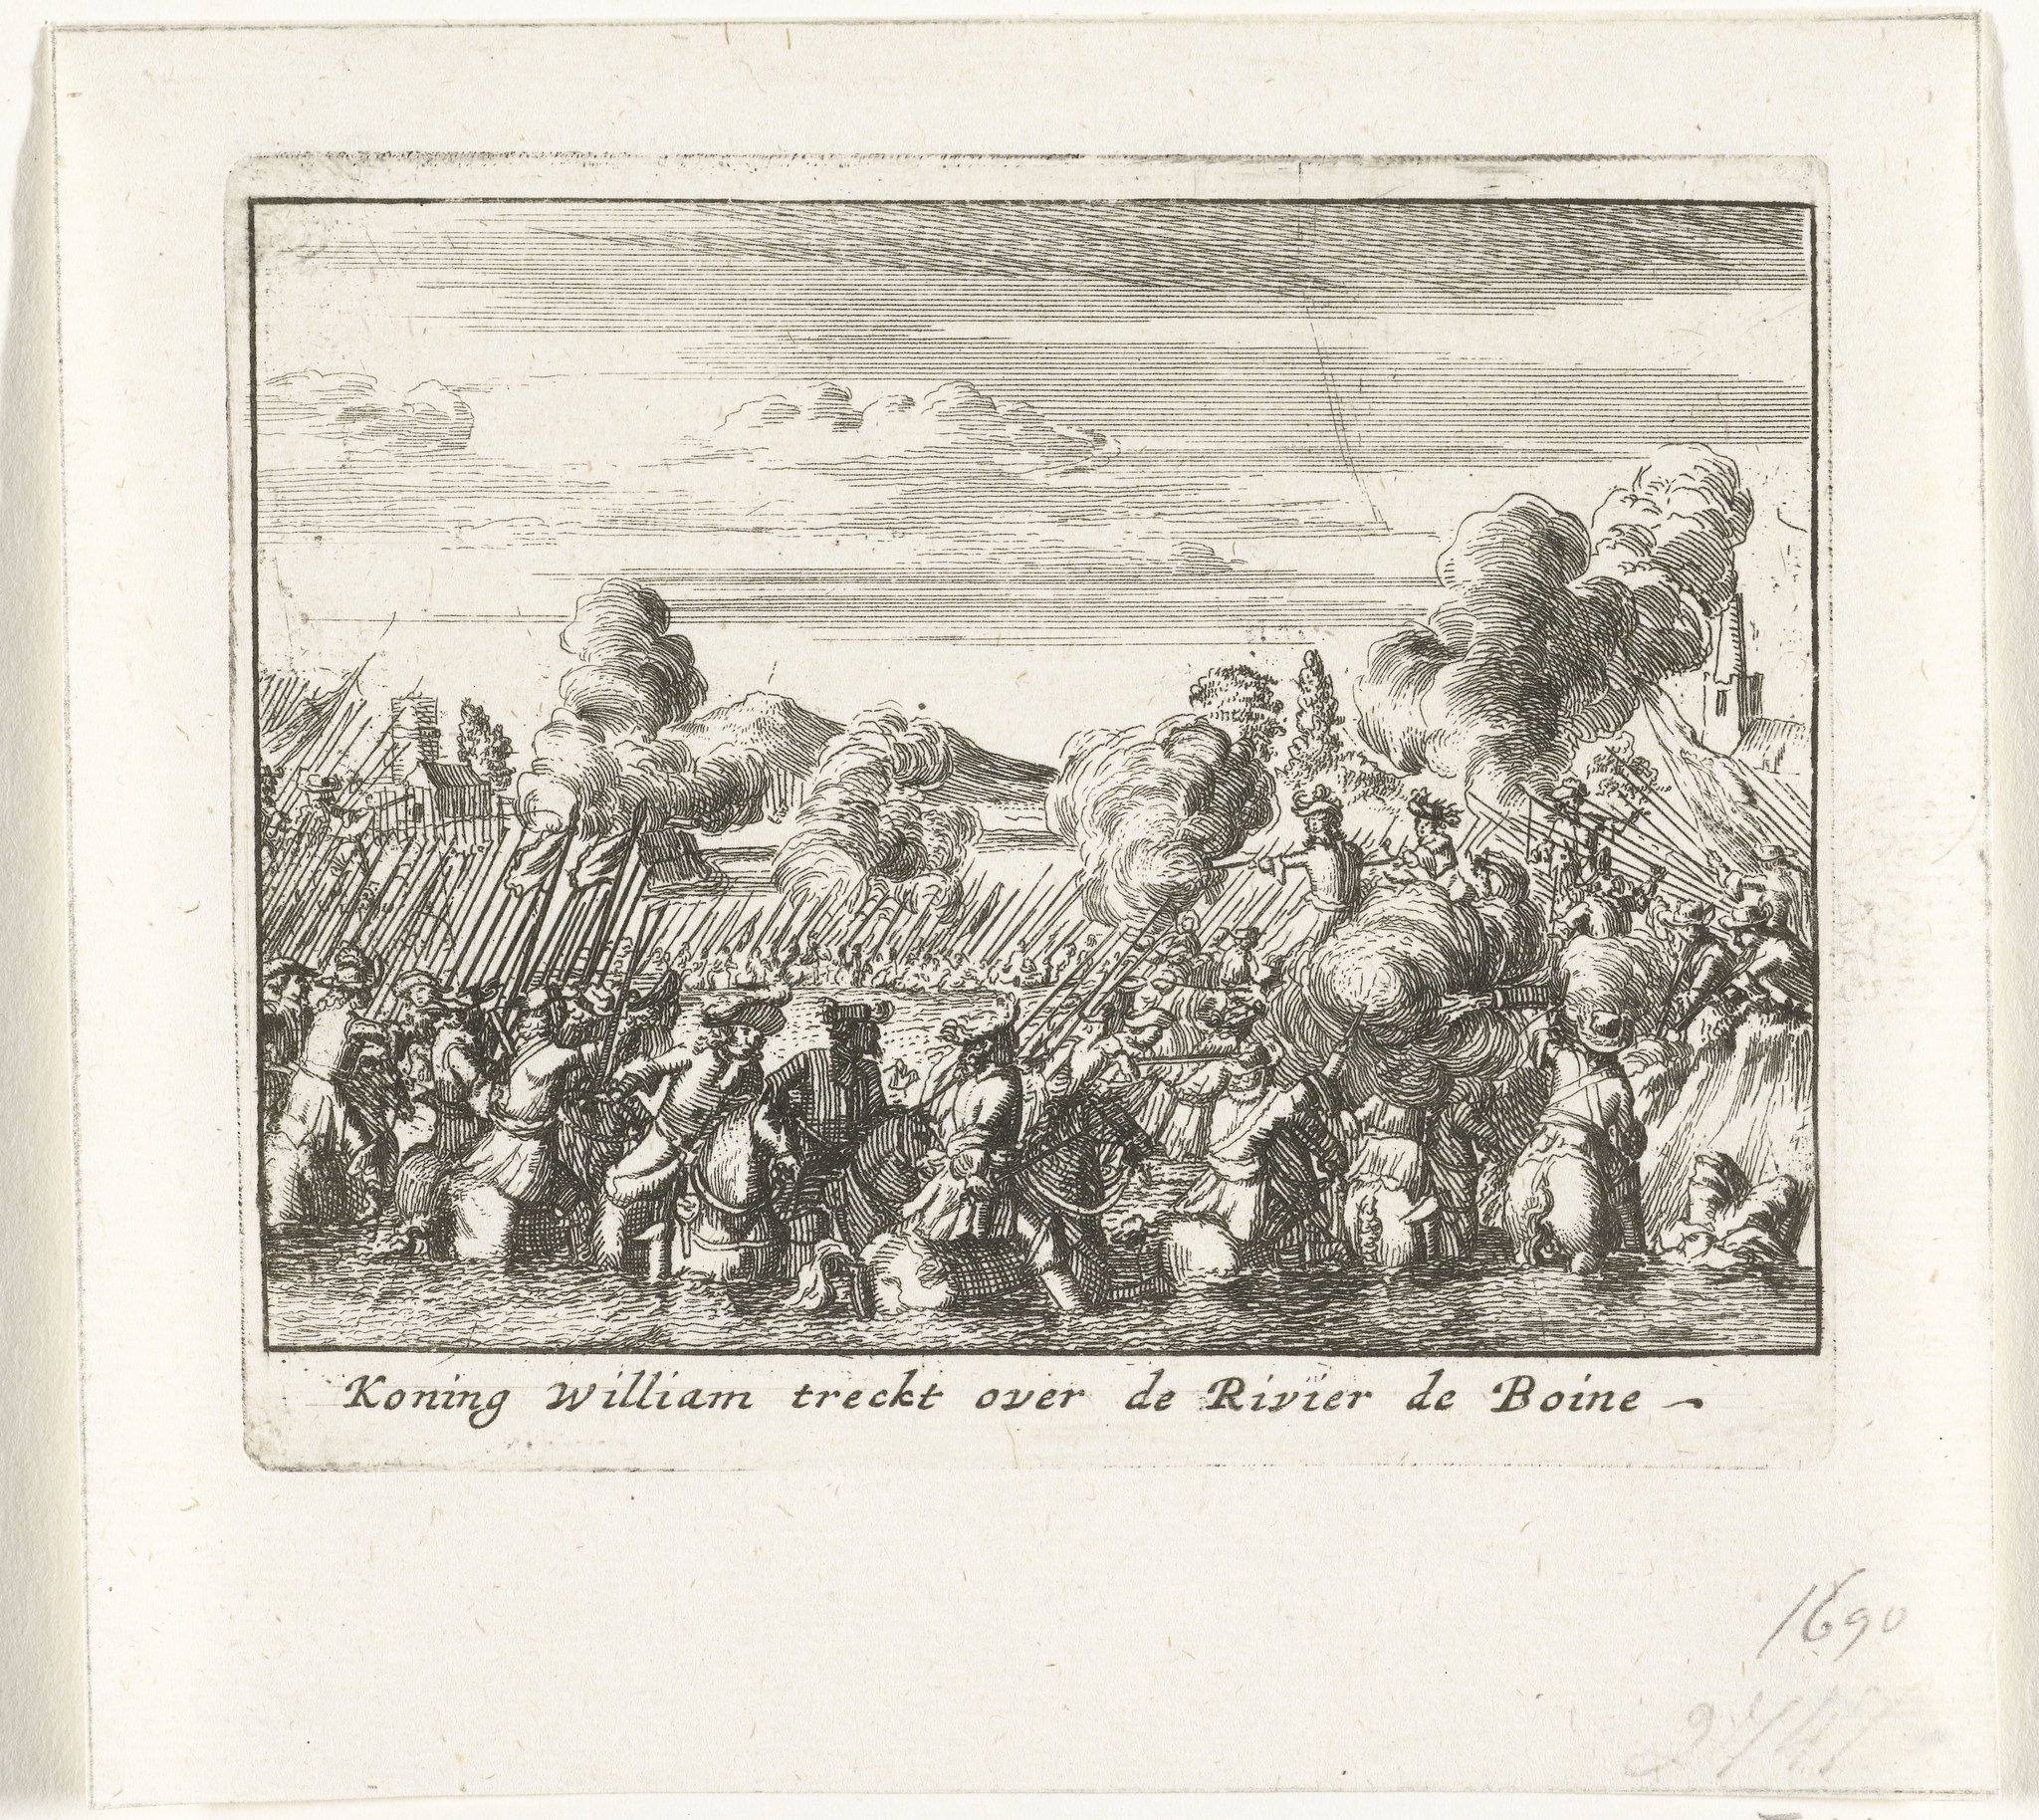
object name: print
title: Kroniek van het huis Stuart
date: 1711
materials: paper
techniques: etching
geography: amsterdam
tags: the hague, william iii (prince of orange and king of england, scotland, and ireland), battle (+ land forces)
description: Slag bij de rivier de Boyne op 11 juli 1690, waarbij het leger van Willem III en overwinning behaalt op de katholieken. Onderdeel van een serie over de lotgevallen van het Engelse koningshuis van Stuart van 1558-1711, waarvan hier zijn opgenomen zestien prenten over de strijd tussen Jacobus II en Willem III in de jaren 1688-1689.